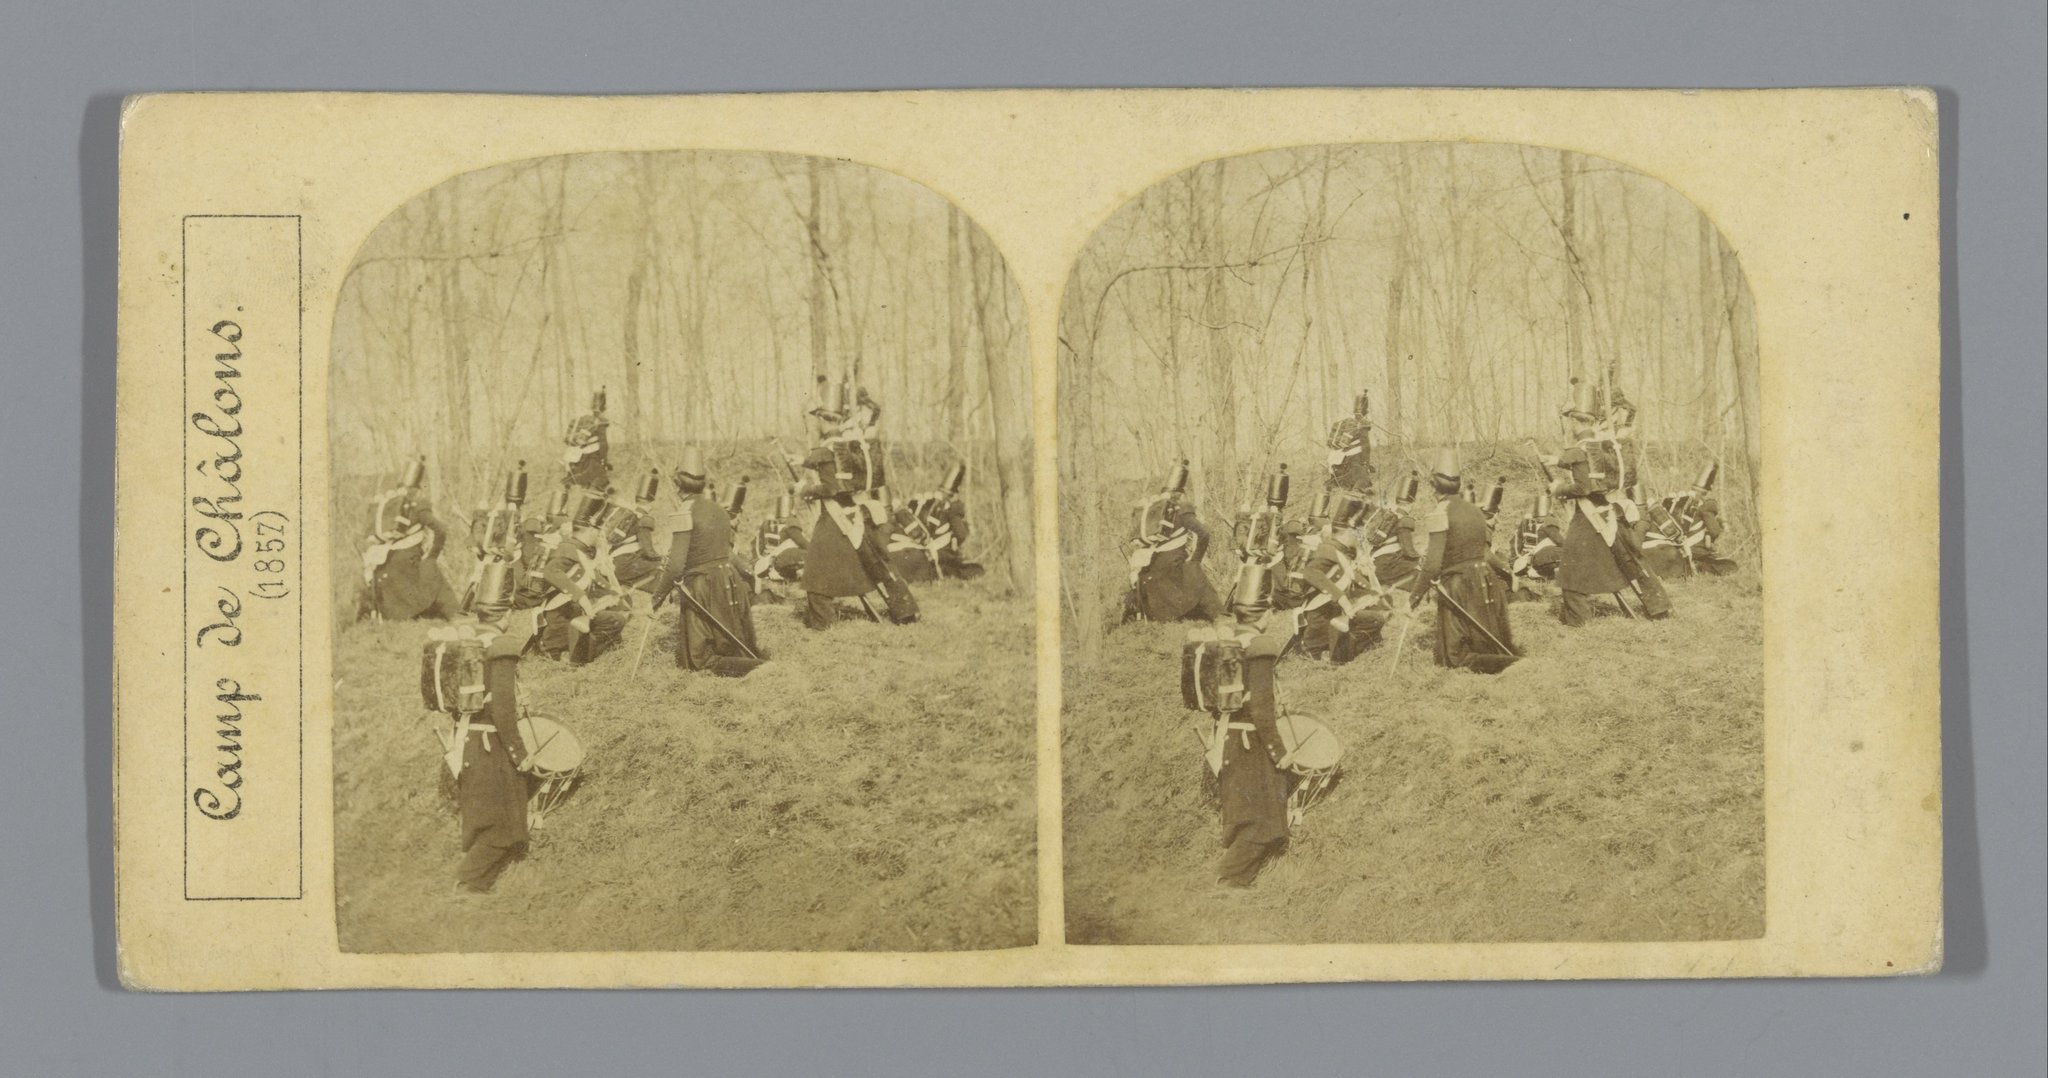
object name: stereograph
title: Soldaten beleggen een hinderlaag in het Camp de Châlons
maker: Anonymous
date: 1857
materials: cardboard, photographic support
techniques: albumen print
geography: mourmelon-le-grand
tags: private soldier, surprise attack (from ambush)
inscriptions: number: ‘No. 3’, inscription: ‘Une embuscade’, number: ‘No 1063’